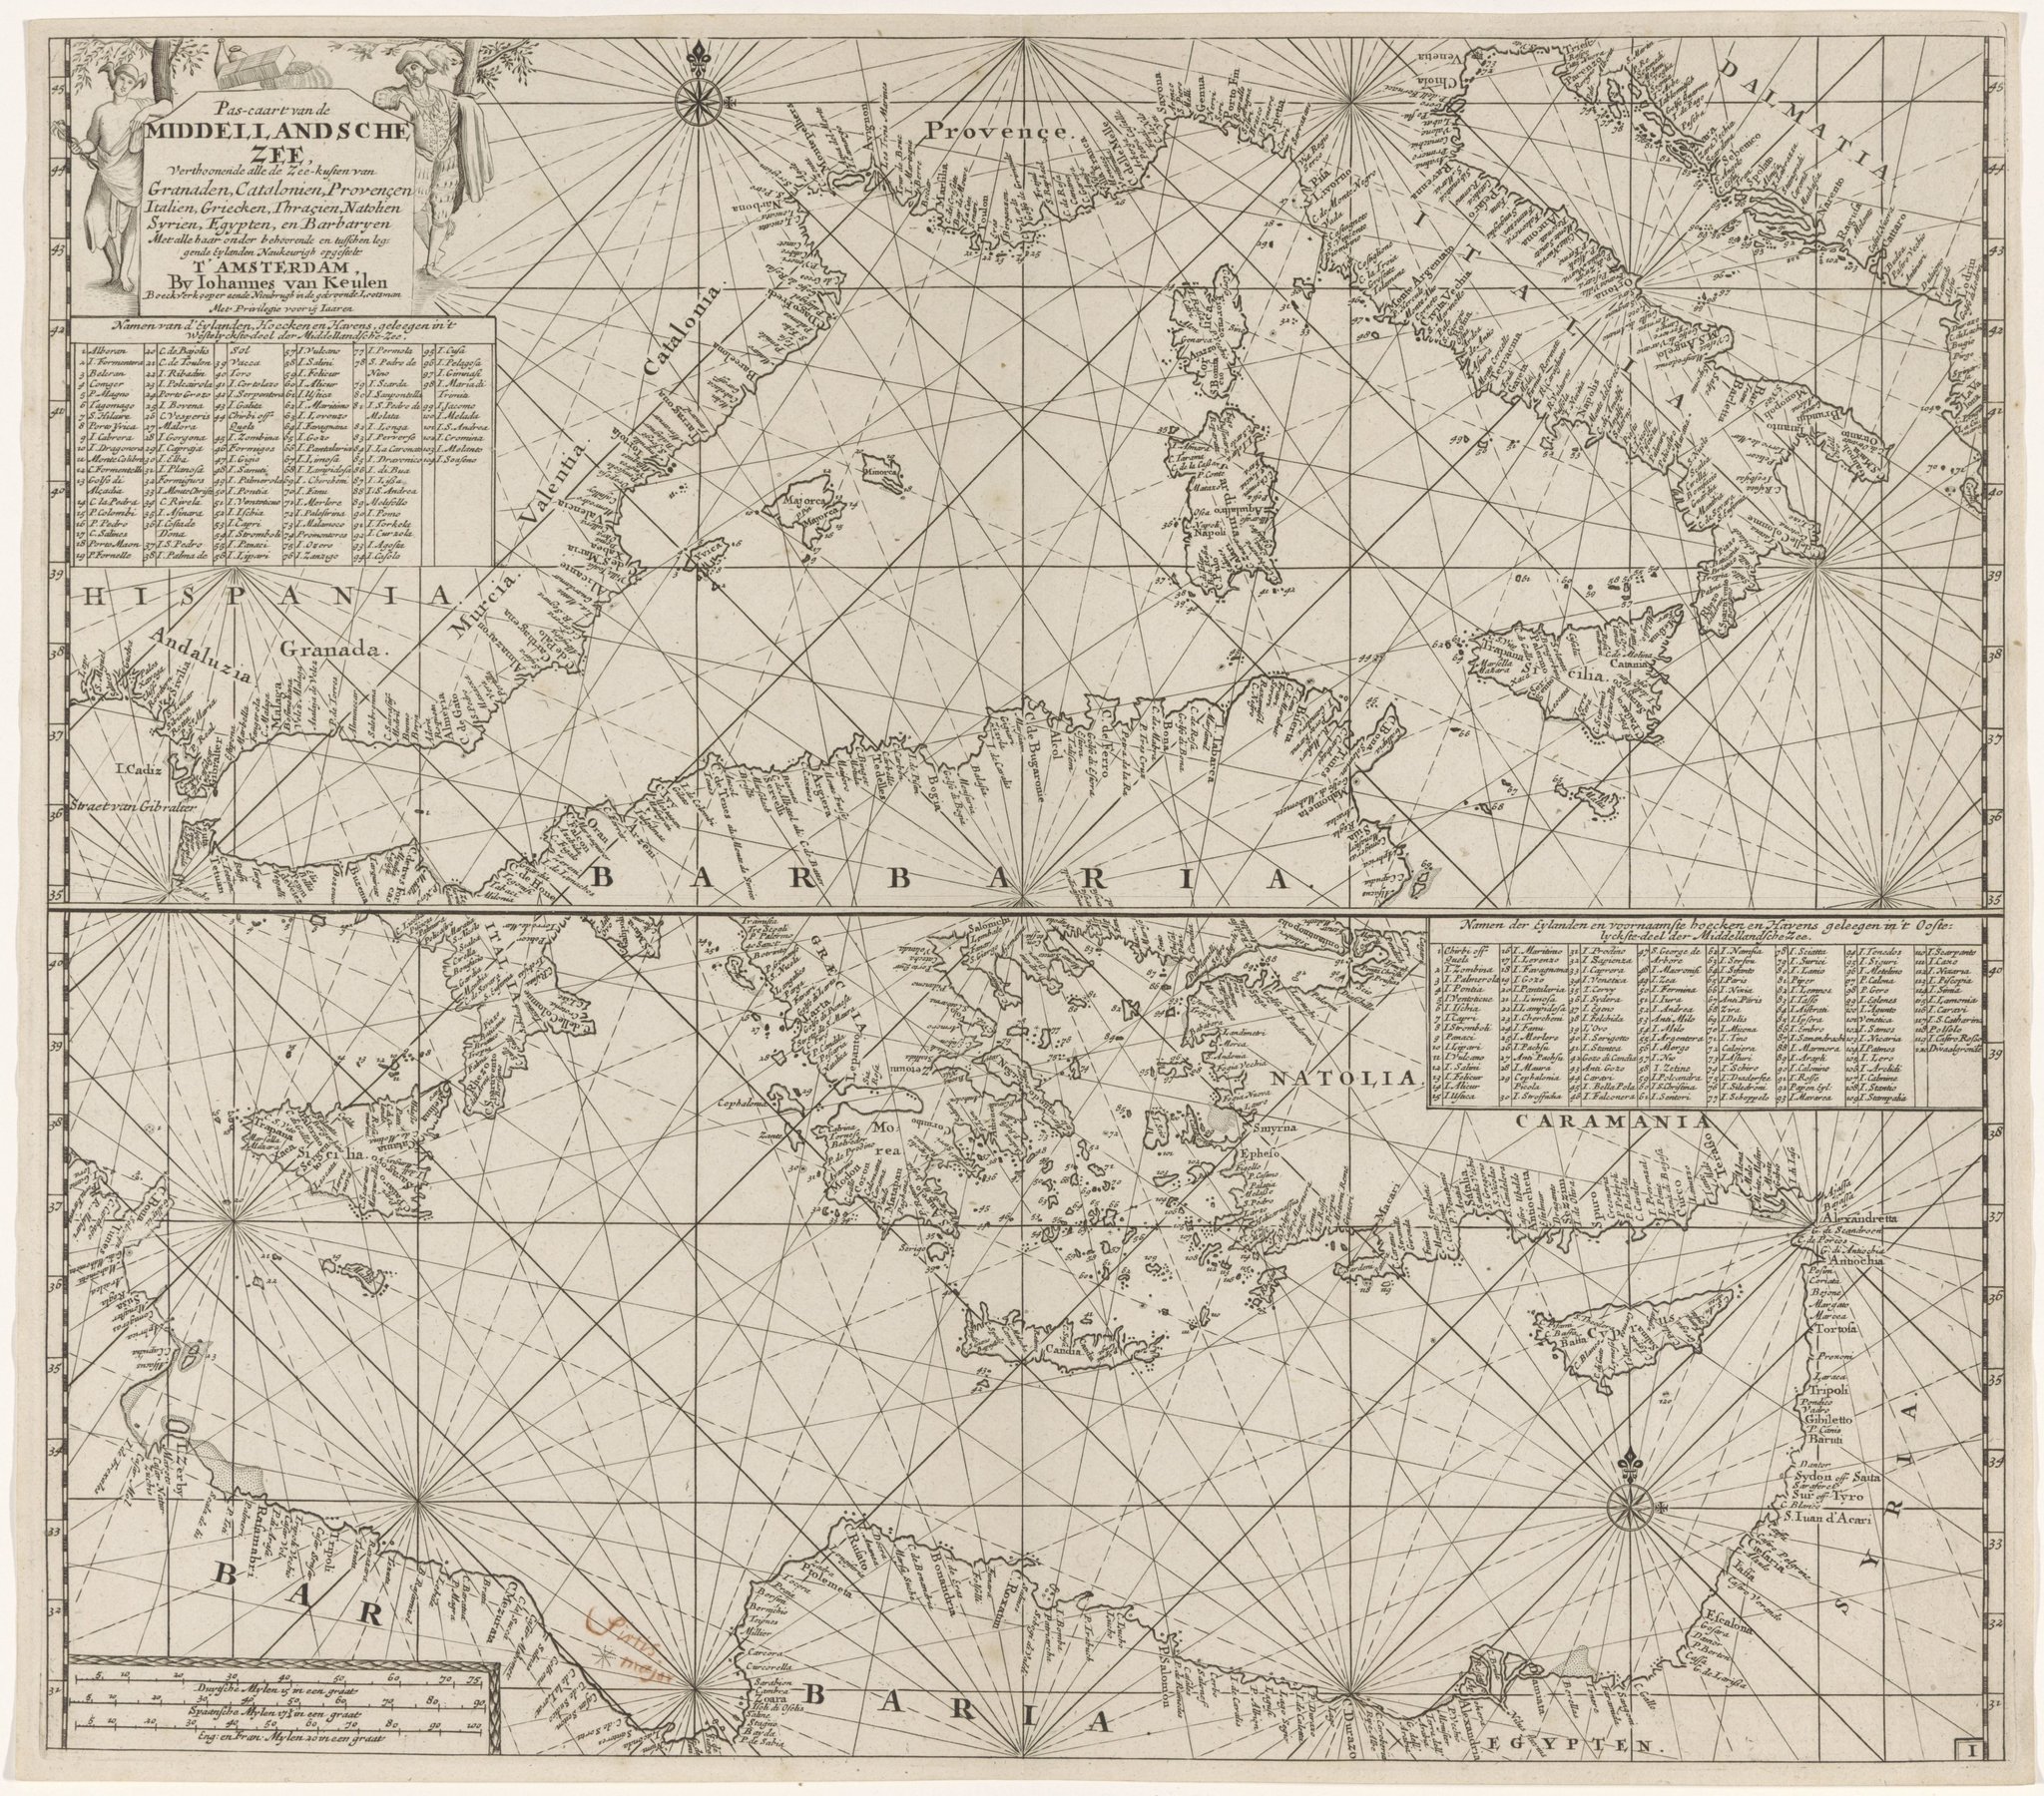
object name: print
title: Kaart van de Middellandse Zee met boven het westelijk deel en onder het oostelijk deel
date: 1682-1803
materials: paper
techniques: engraving, etching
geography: amsterdam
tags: (story of) mercury (hermes)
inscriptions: collector's mark: Lugt 2228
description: Kaart van de Middellandse Zee met boven het westelijk deel en onder het oostelijk deel, met twee kompasrozen, het Noorden ligt boven. Linksboven Mercurius en een heer bij de titel, het uitgeversadres en een lijst met namen van belangrijke eilanden en havens, gelegen in het westelijk deel. Rechts een vergelijkbare lijst voor het oostelijk deel. Linksonder de schaalverdeling, weergegeven in Duitse, Spaanse en Engelse of Franse mijlen (schaal: c. 1:4.500.000).